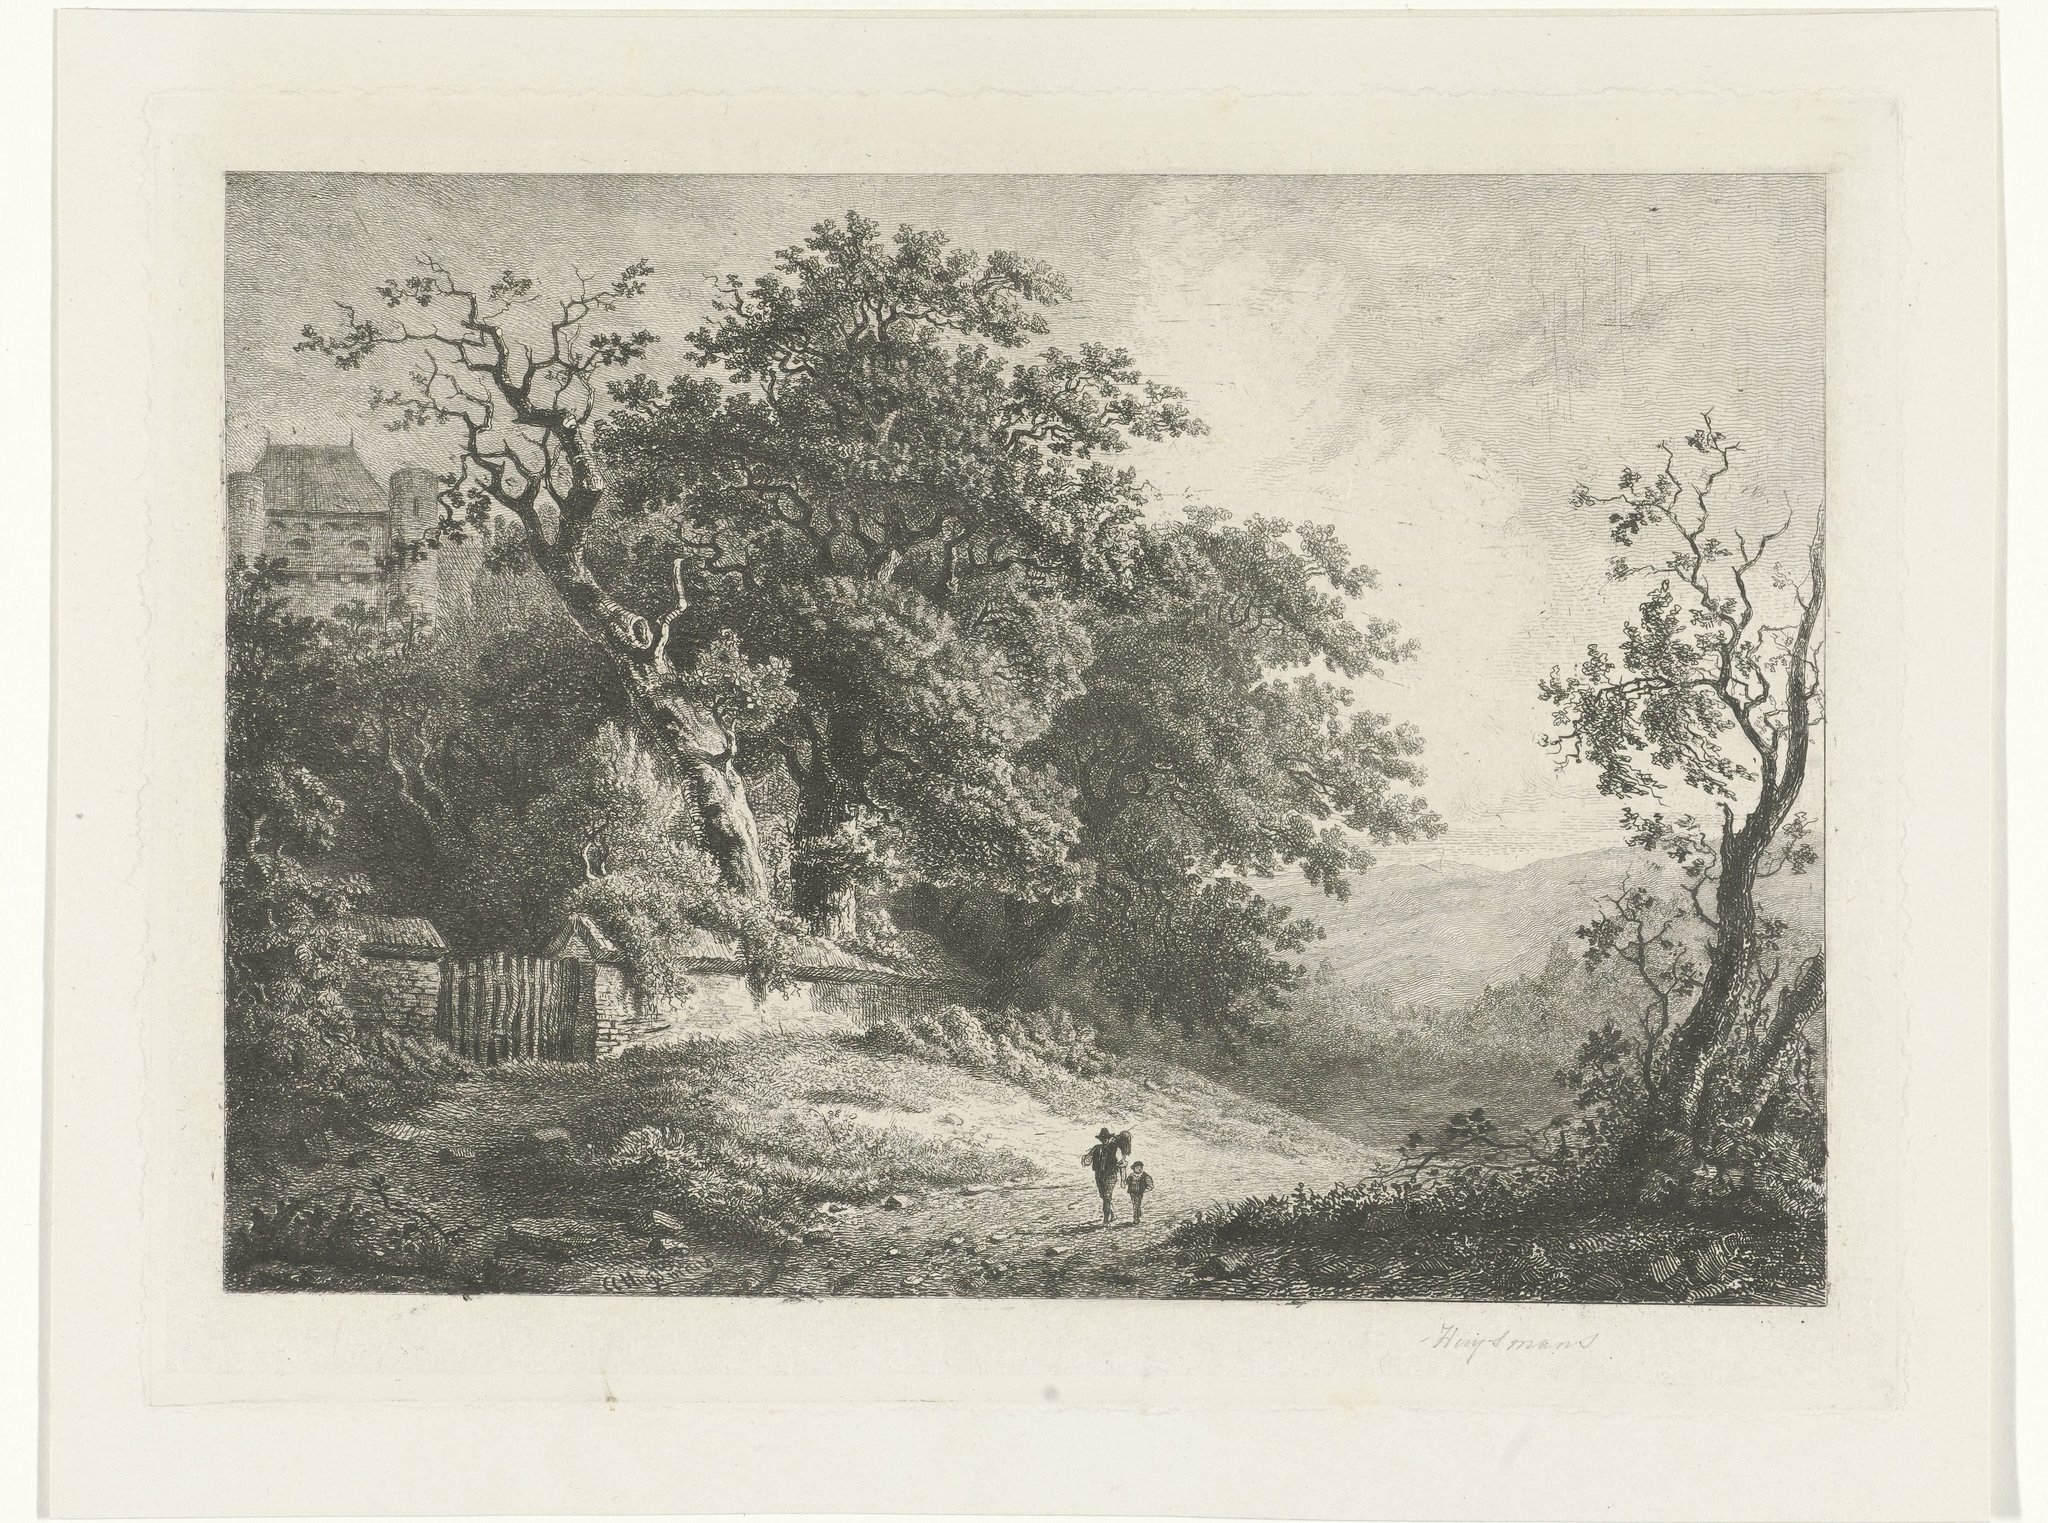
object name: print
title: Landschap met bomen en kasteel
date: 1820-1886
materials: paper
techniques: etching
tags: castle, landscapes in the temperate zone (+ landscape with figures, staffage)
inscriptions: collector's mark: Lugt 2228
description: Een man en jongen wandelen op een weg. Links een muur met hek, bomen en een kasteel.